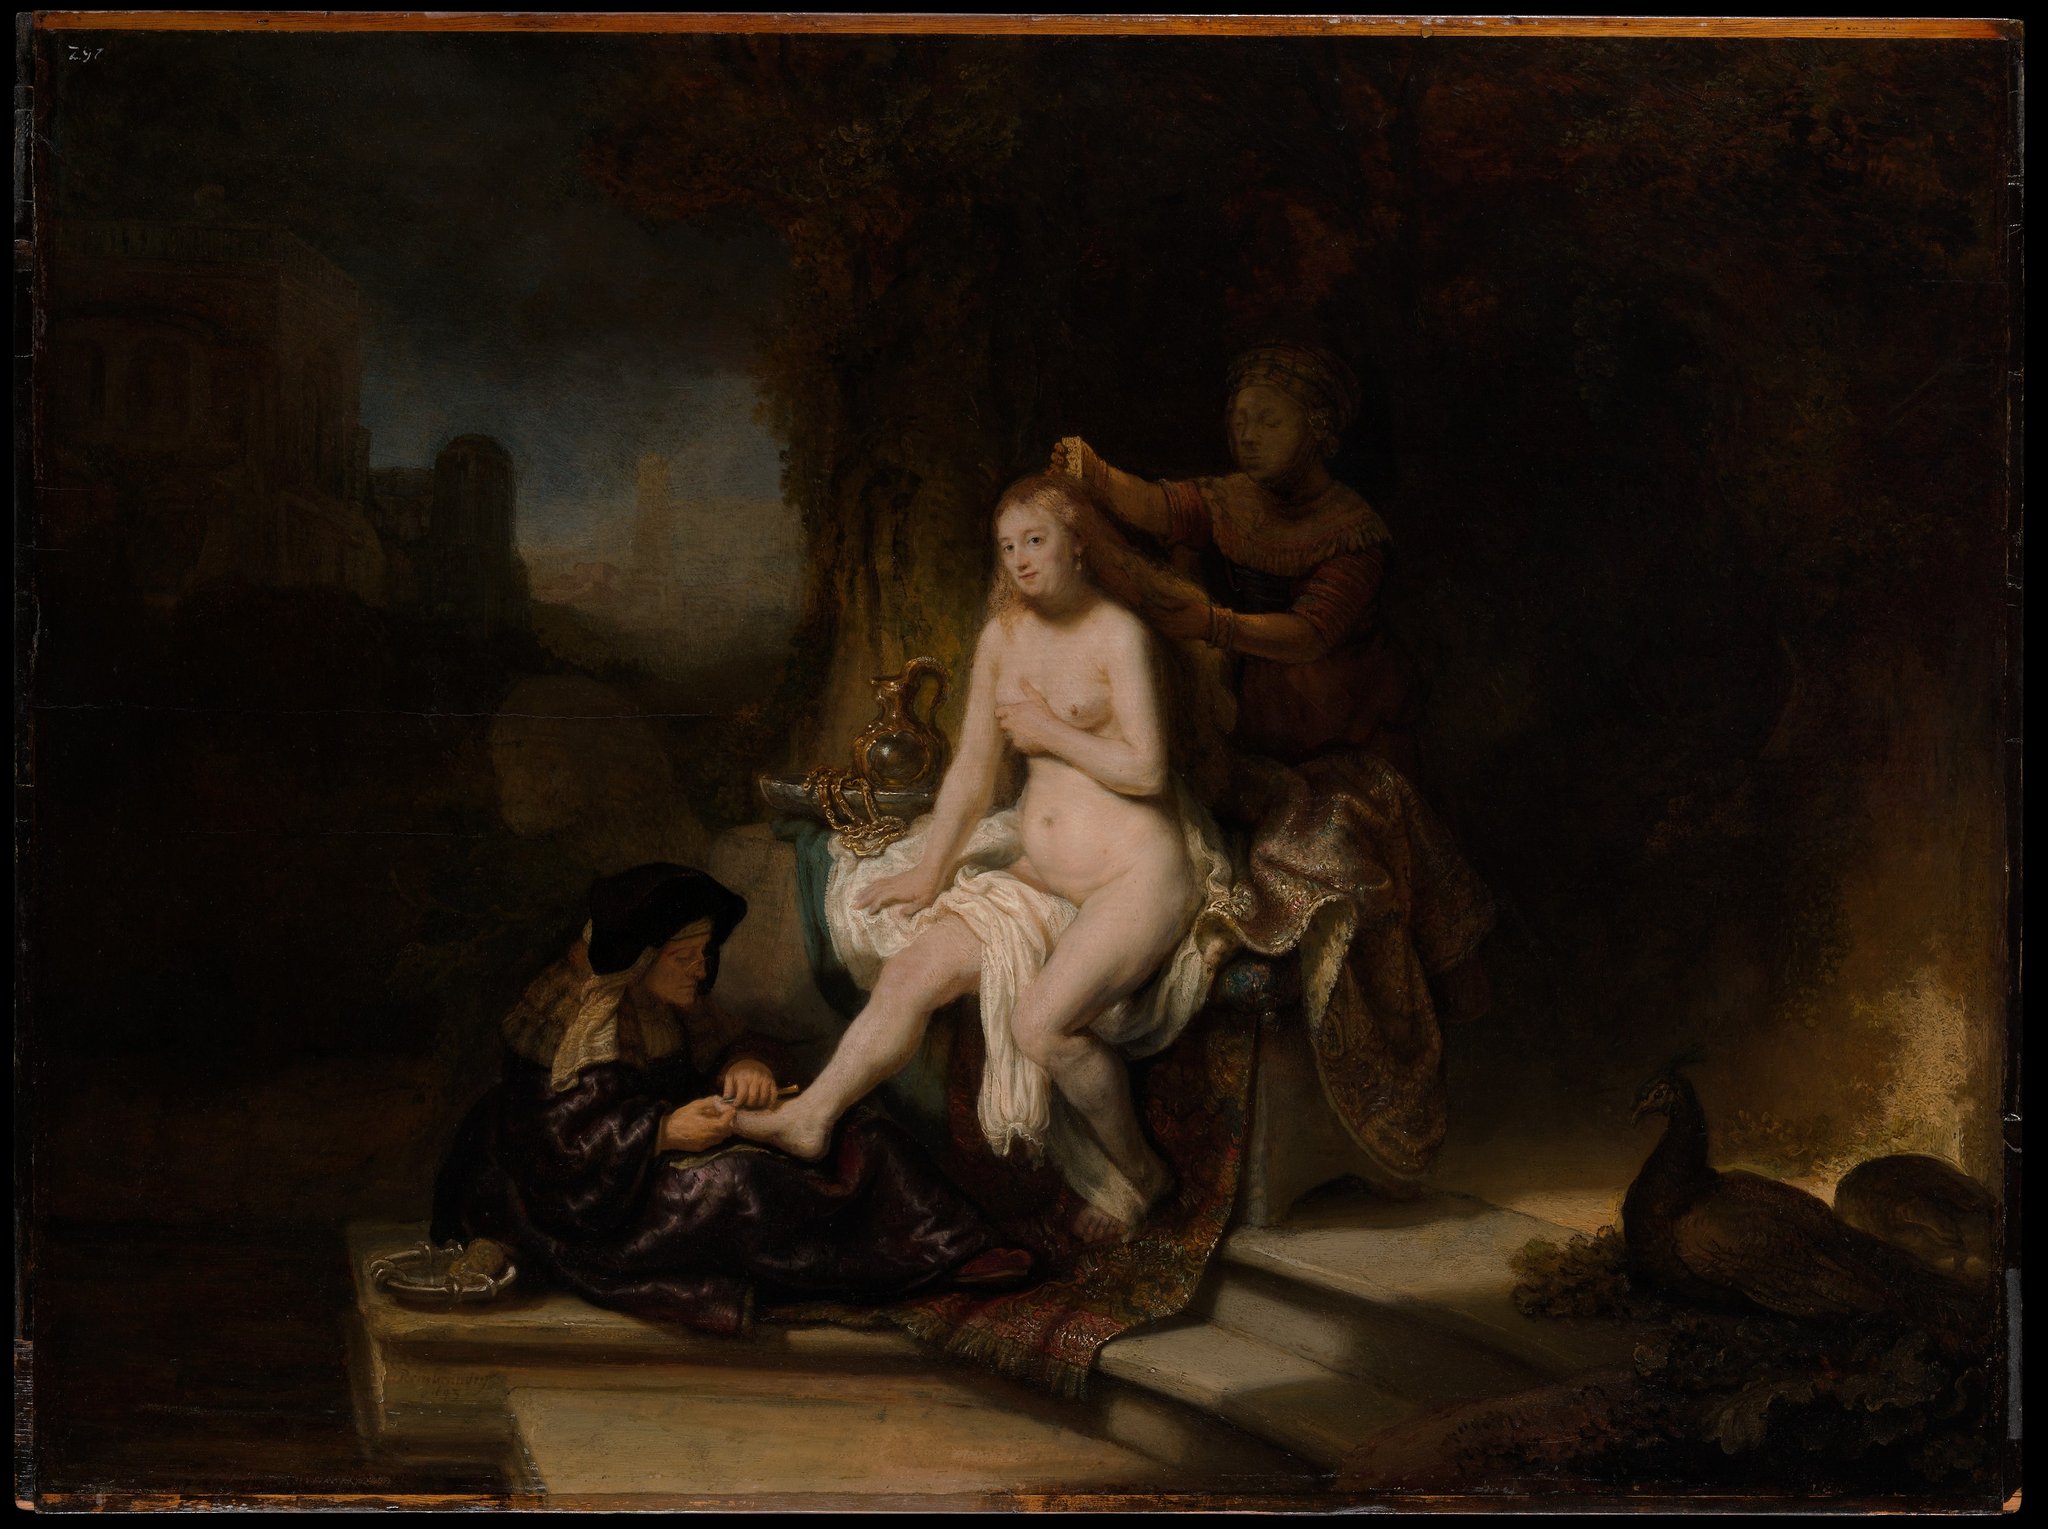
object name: painting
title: The Toilet of Bathsheba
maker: rembrandt van rijn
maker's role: artist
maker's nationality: dutch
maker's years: 1606-1669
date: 1643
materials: oil, wood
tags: female nudes,bathsheba